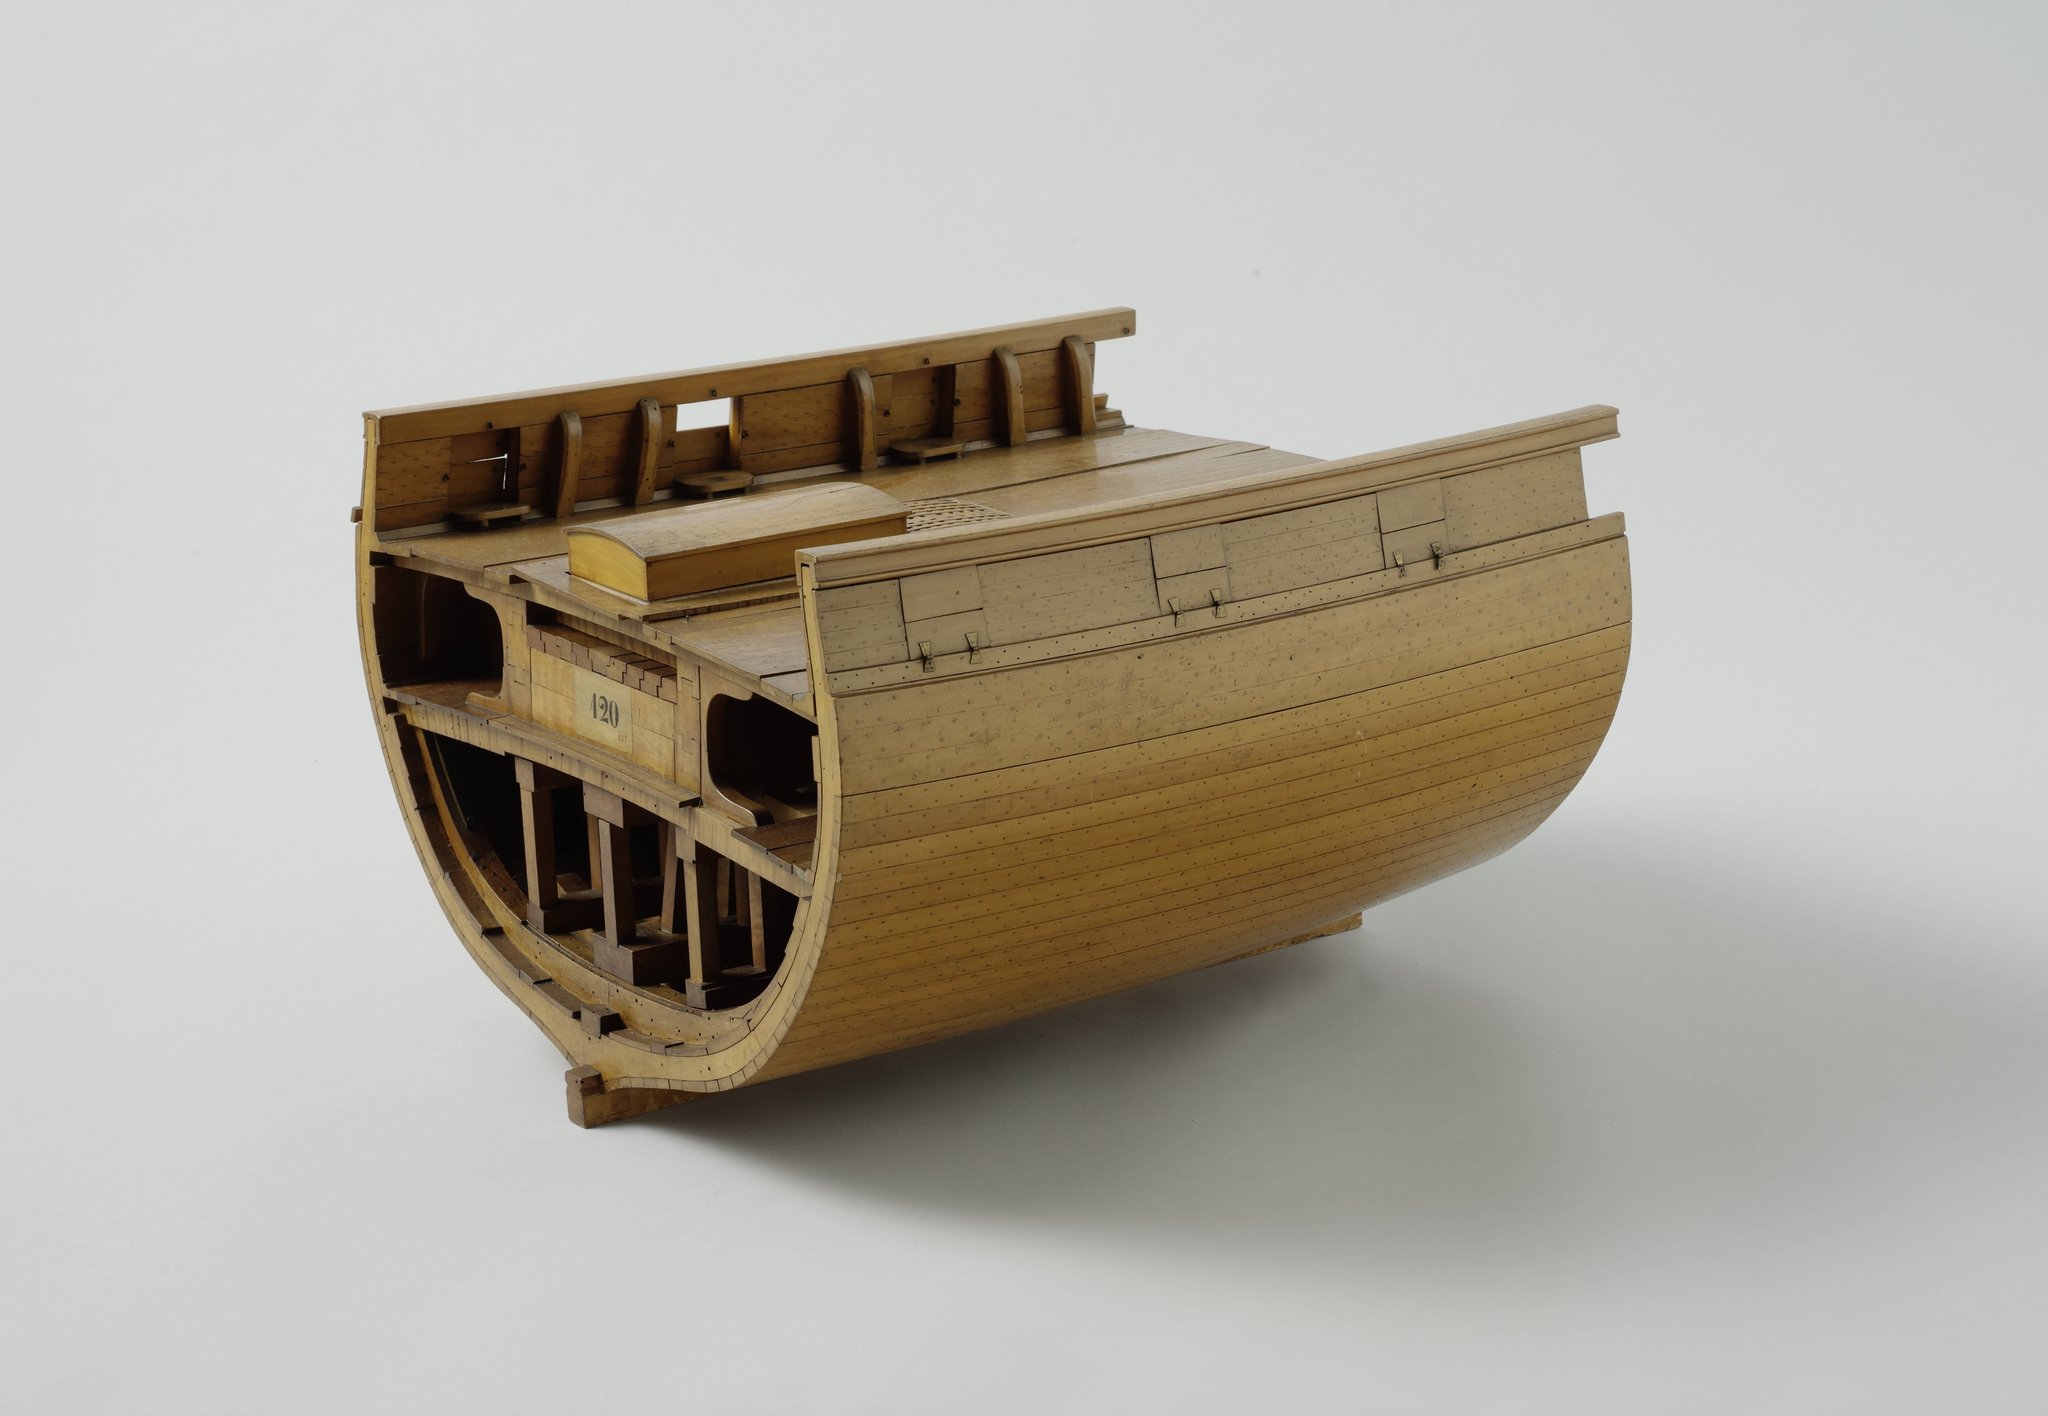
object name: demonstration model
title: Model of the Mortar Bed of a Bomb Sloop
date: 1842-1847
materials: brass, iron, wood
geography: rotterdam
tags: proserpina (schip), medusa (schip), hekla (schip)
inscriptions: label, on the wall: ‘120’ former inventory label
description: Model van de dwarsdoorsnede van een schip, waarop de constructie van de ondersteuning van een mortierstelling is aangegeven. Het schip heeft twee dekken; in het ruim onder de mortierstelling zijn vijf kattesporen om en om aangebracht. Tussendeks zijn in lengterichting twee wanden aangebracht van opeengestapelde balken, verbonden door zwaluwstaarten, die het bovendek ondersteunen. De constructie is volgebouwd met balken en stutten, in het ruim met drie rijen zware stutten. Het geheel is afgewerkt met een groot aantal toegevoegd metalen en kunstknieën. Op het bovendek is de pivot aangebracht onder een rechthoekige houten kap en delen van het dek, die verwijderd kunnen worden. In het dek is ook een luik met roosters aangebracht. Op het bovendek zijn aan iedere zijde drie geschutpoorten voor carronaden aangebracht. Schaal 1:20 (volgens Obreen).